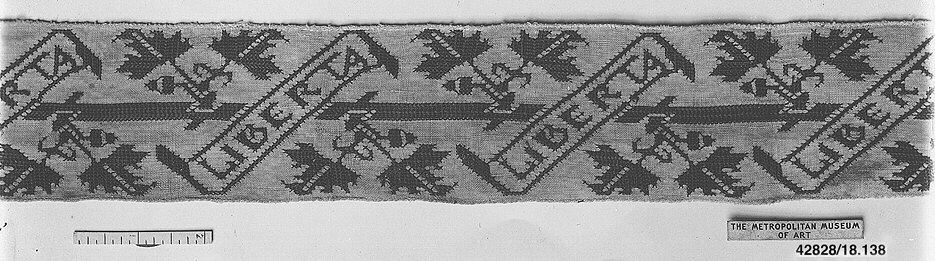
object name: band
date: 1501-1600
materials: linen, silk